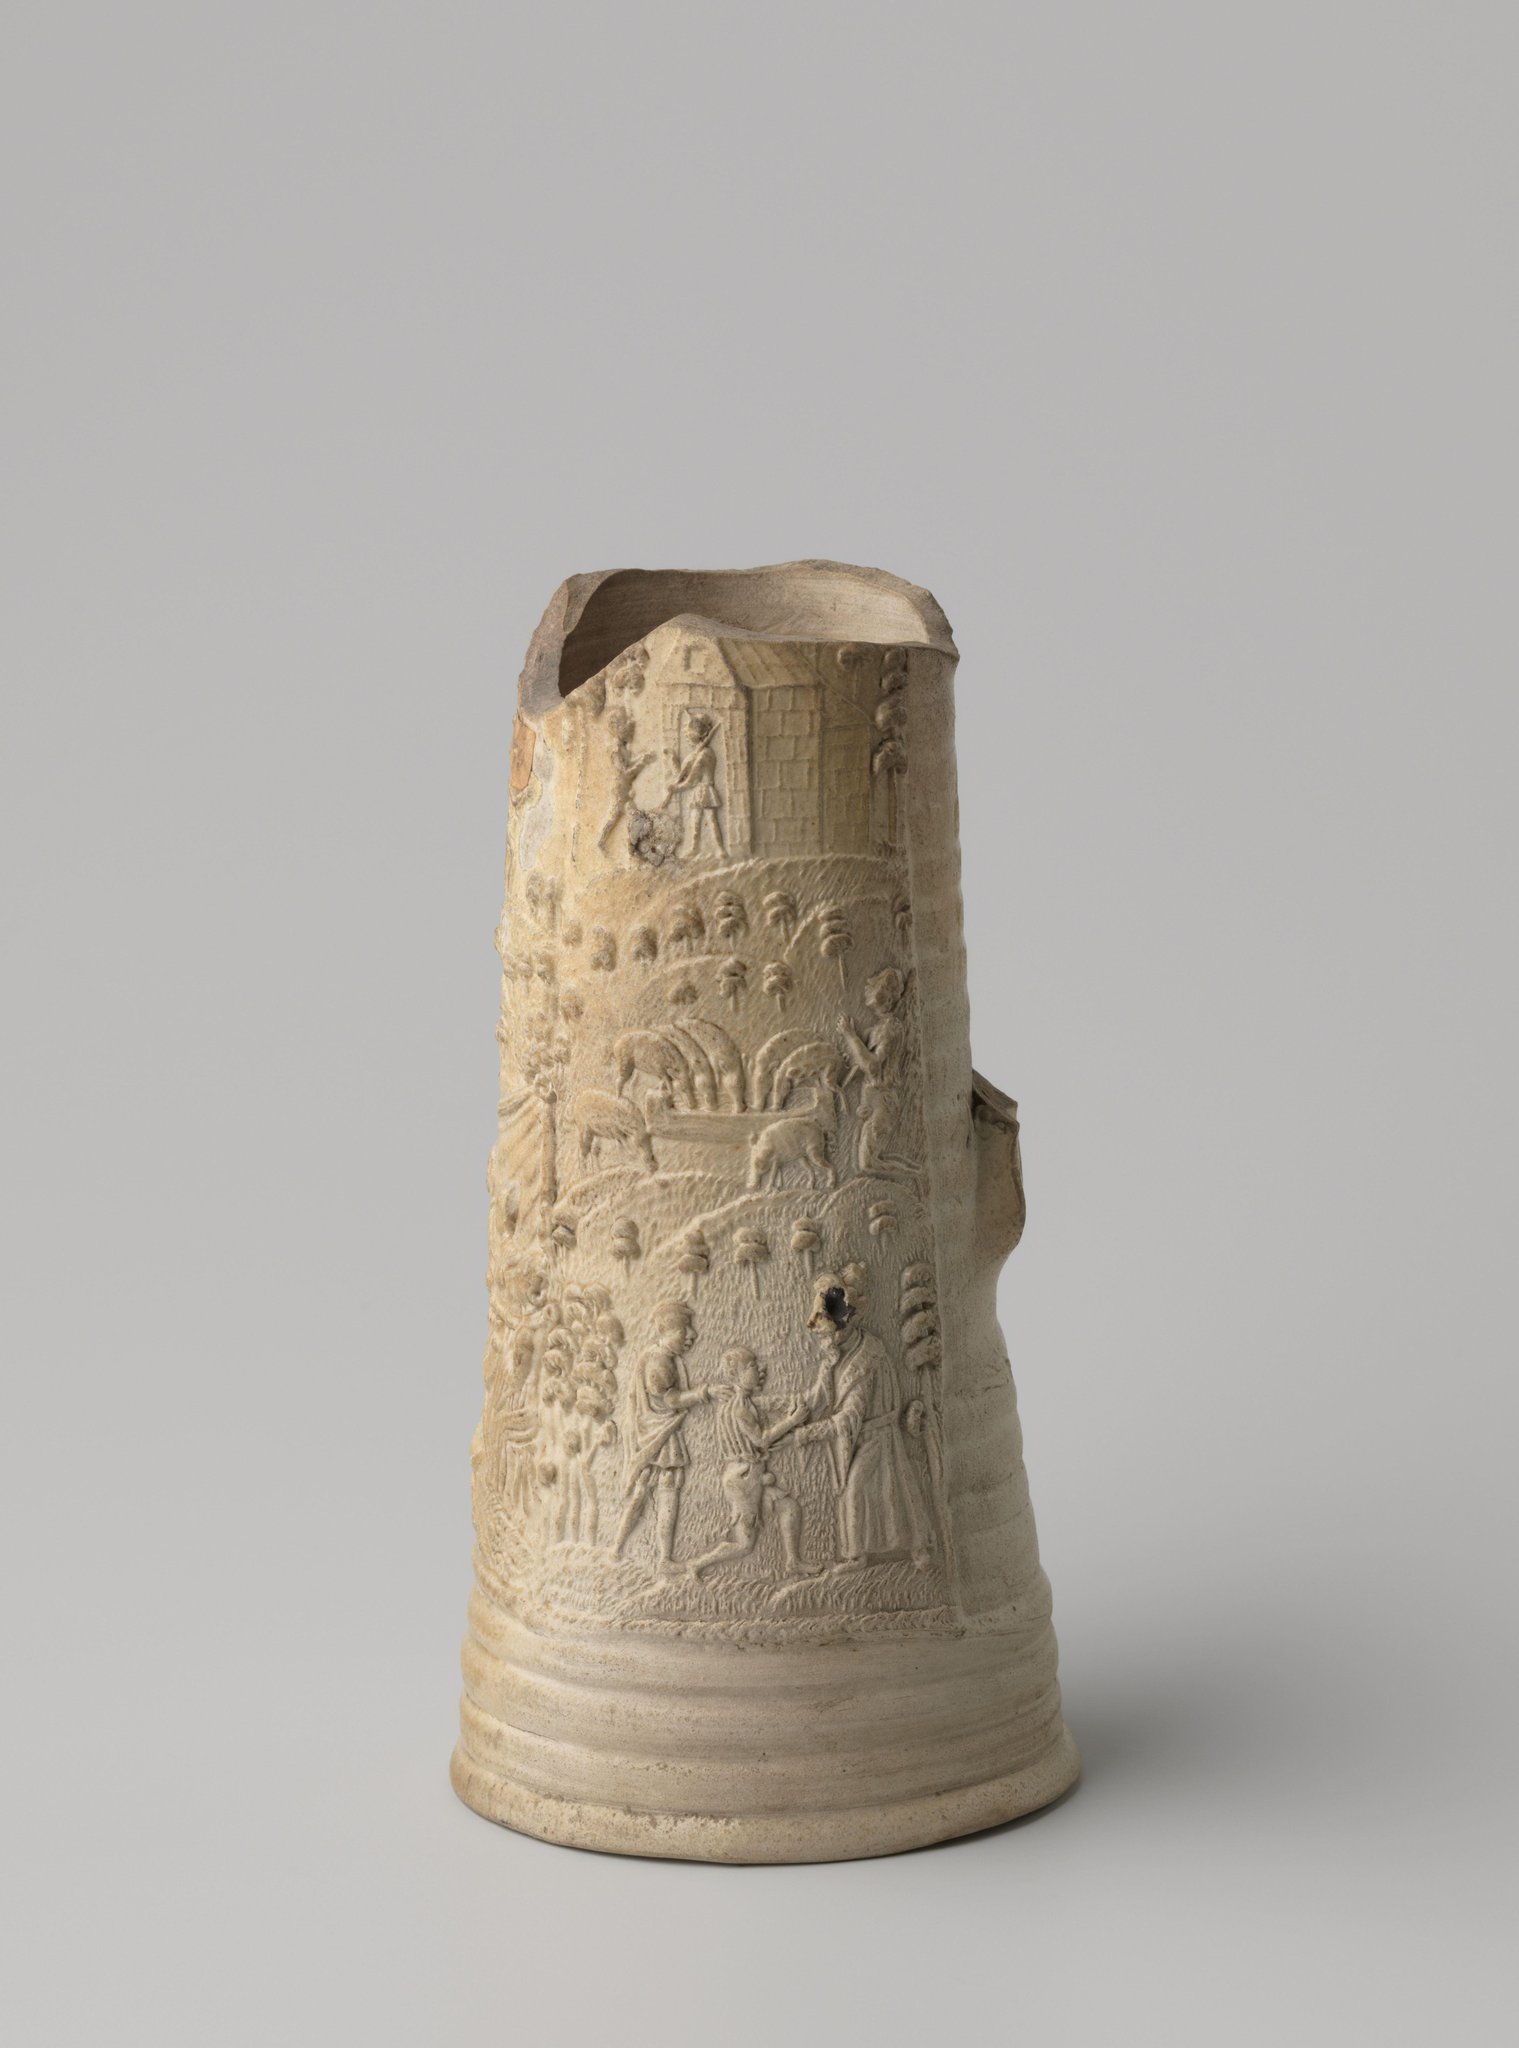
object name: schnelle, snel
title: Fragment of a tankard (schnelle) with scenes from the Prodical Son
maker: Anonymous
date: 1570-1580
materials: glaze, stoneware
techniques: firing, forming, relief, turning, vitrification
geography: siegburg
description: Fragment van een kruik (schnelle) van steengoed met cilindervormig, taps toelopend lichaam. Oor en rand ontbreken. Profielen boven de voet. Op het lichaam in reliëf driemaal een gedrukt en opgelegd, langwerpig vak met daarin voorstellingen van de verloren zoon. Siegburg.